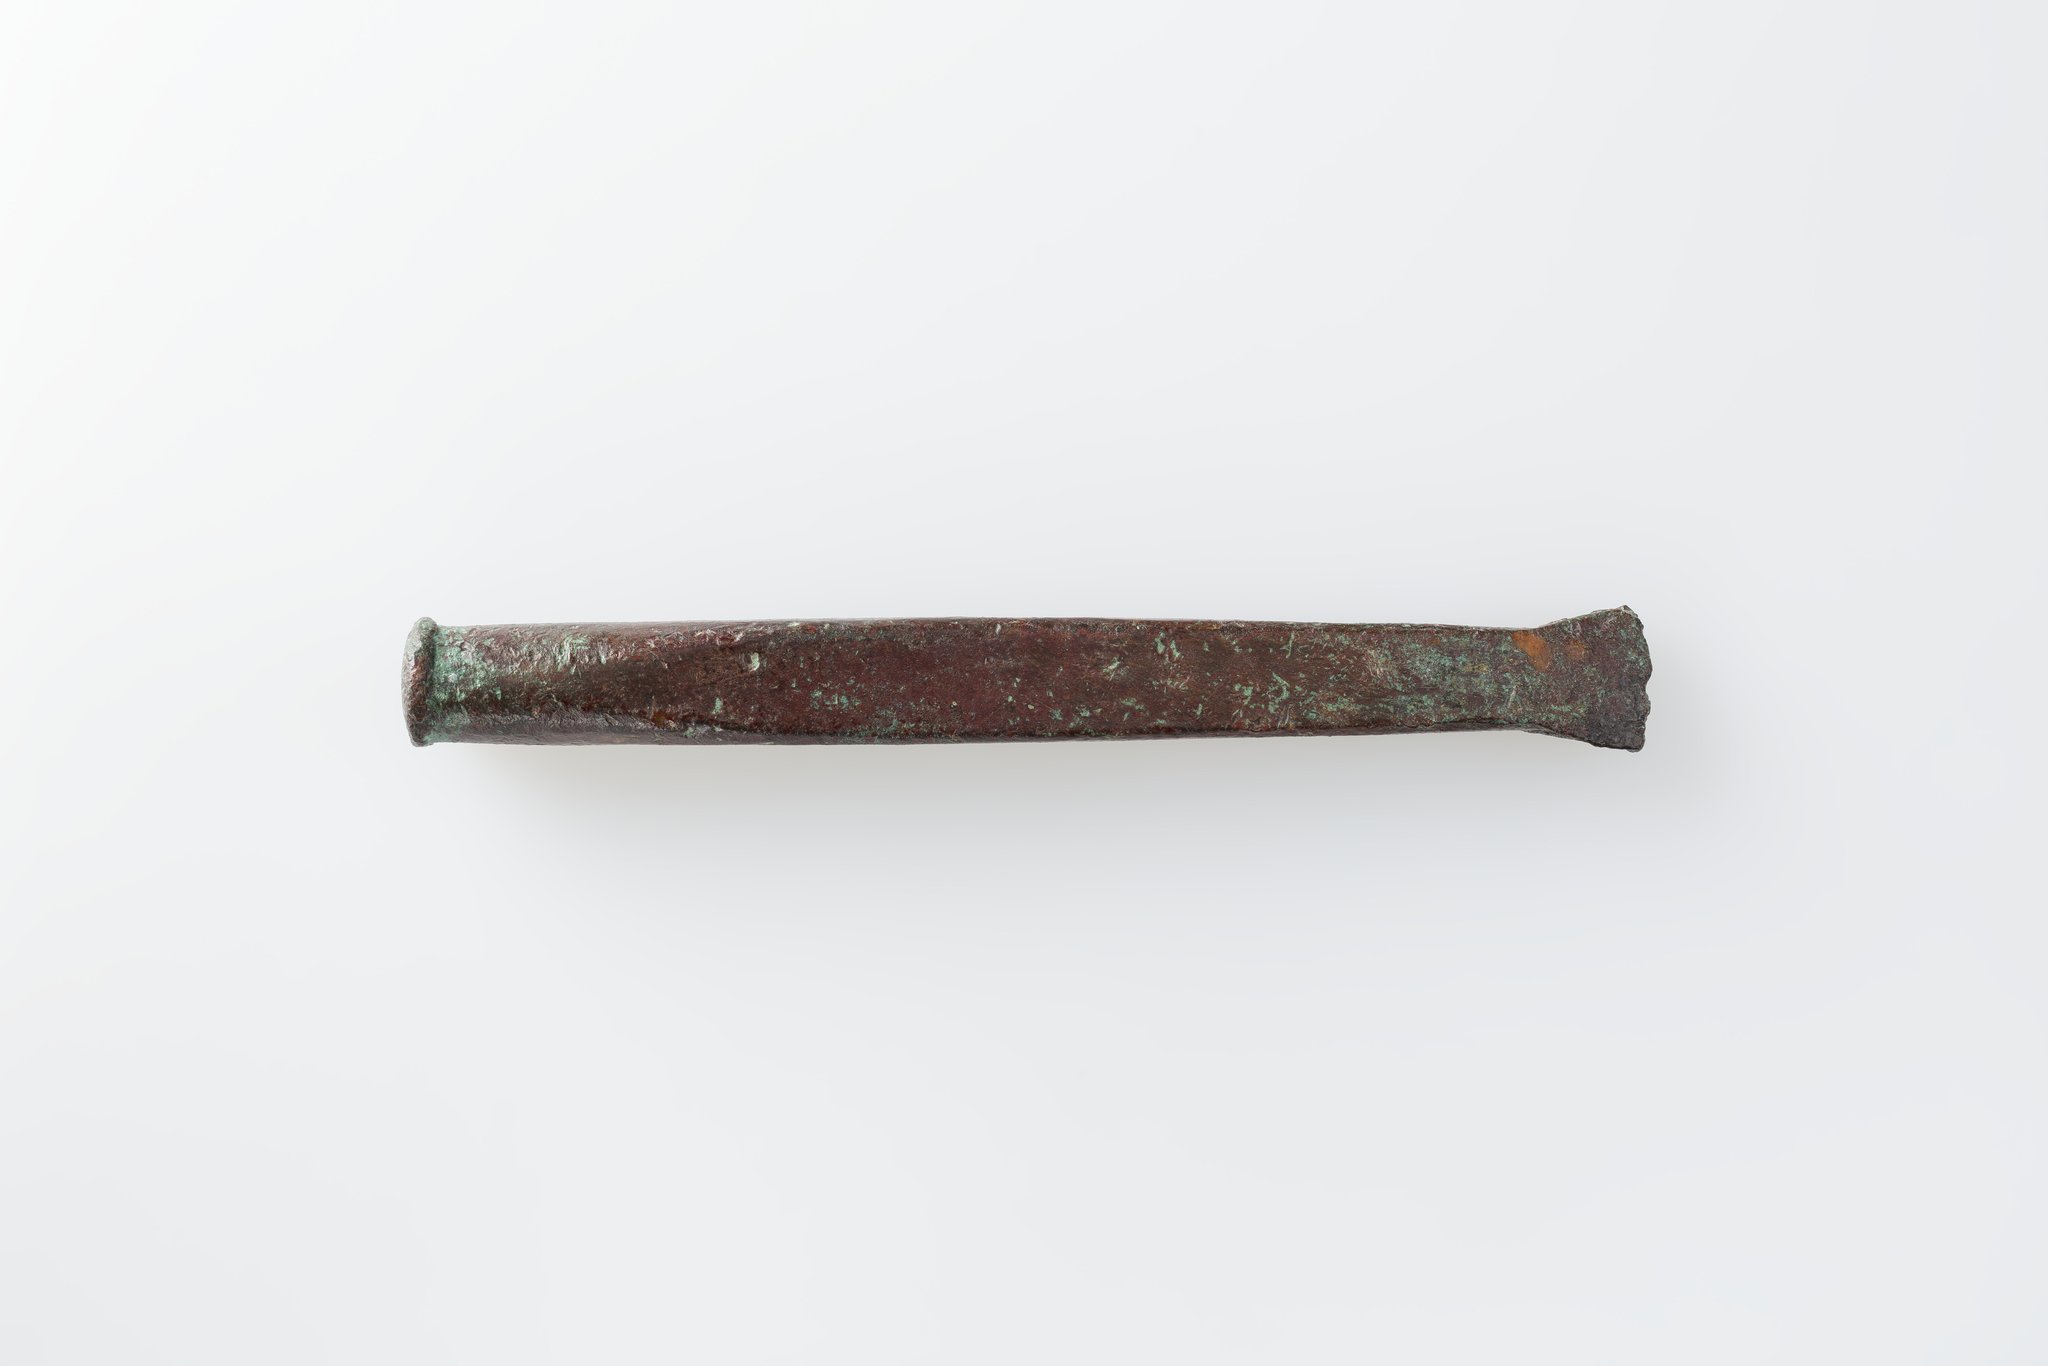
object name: chisel, bronze or copper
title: Stone Mason's Chisel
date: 2051-2000 BCE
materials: bronze, copper alloy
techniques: hammering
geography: egypt